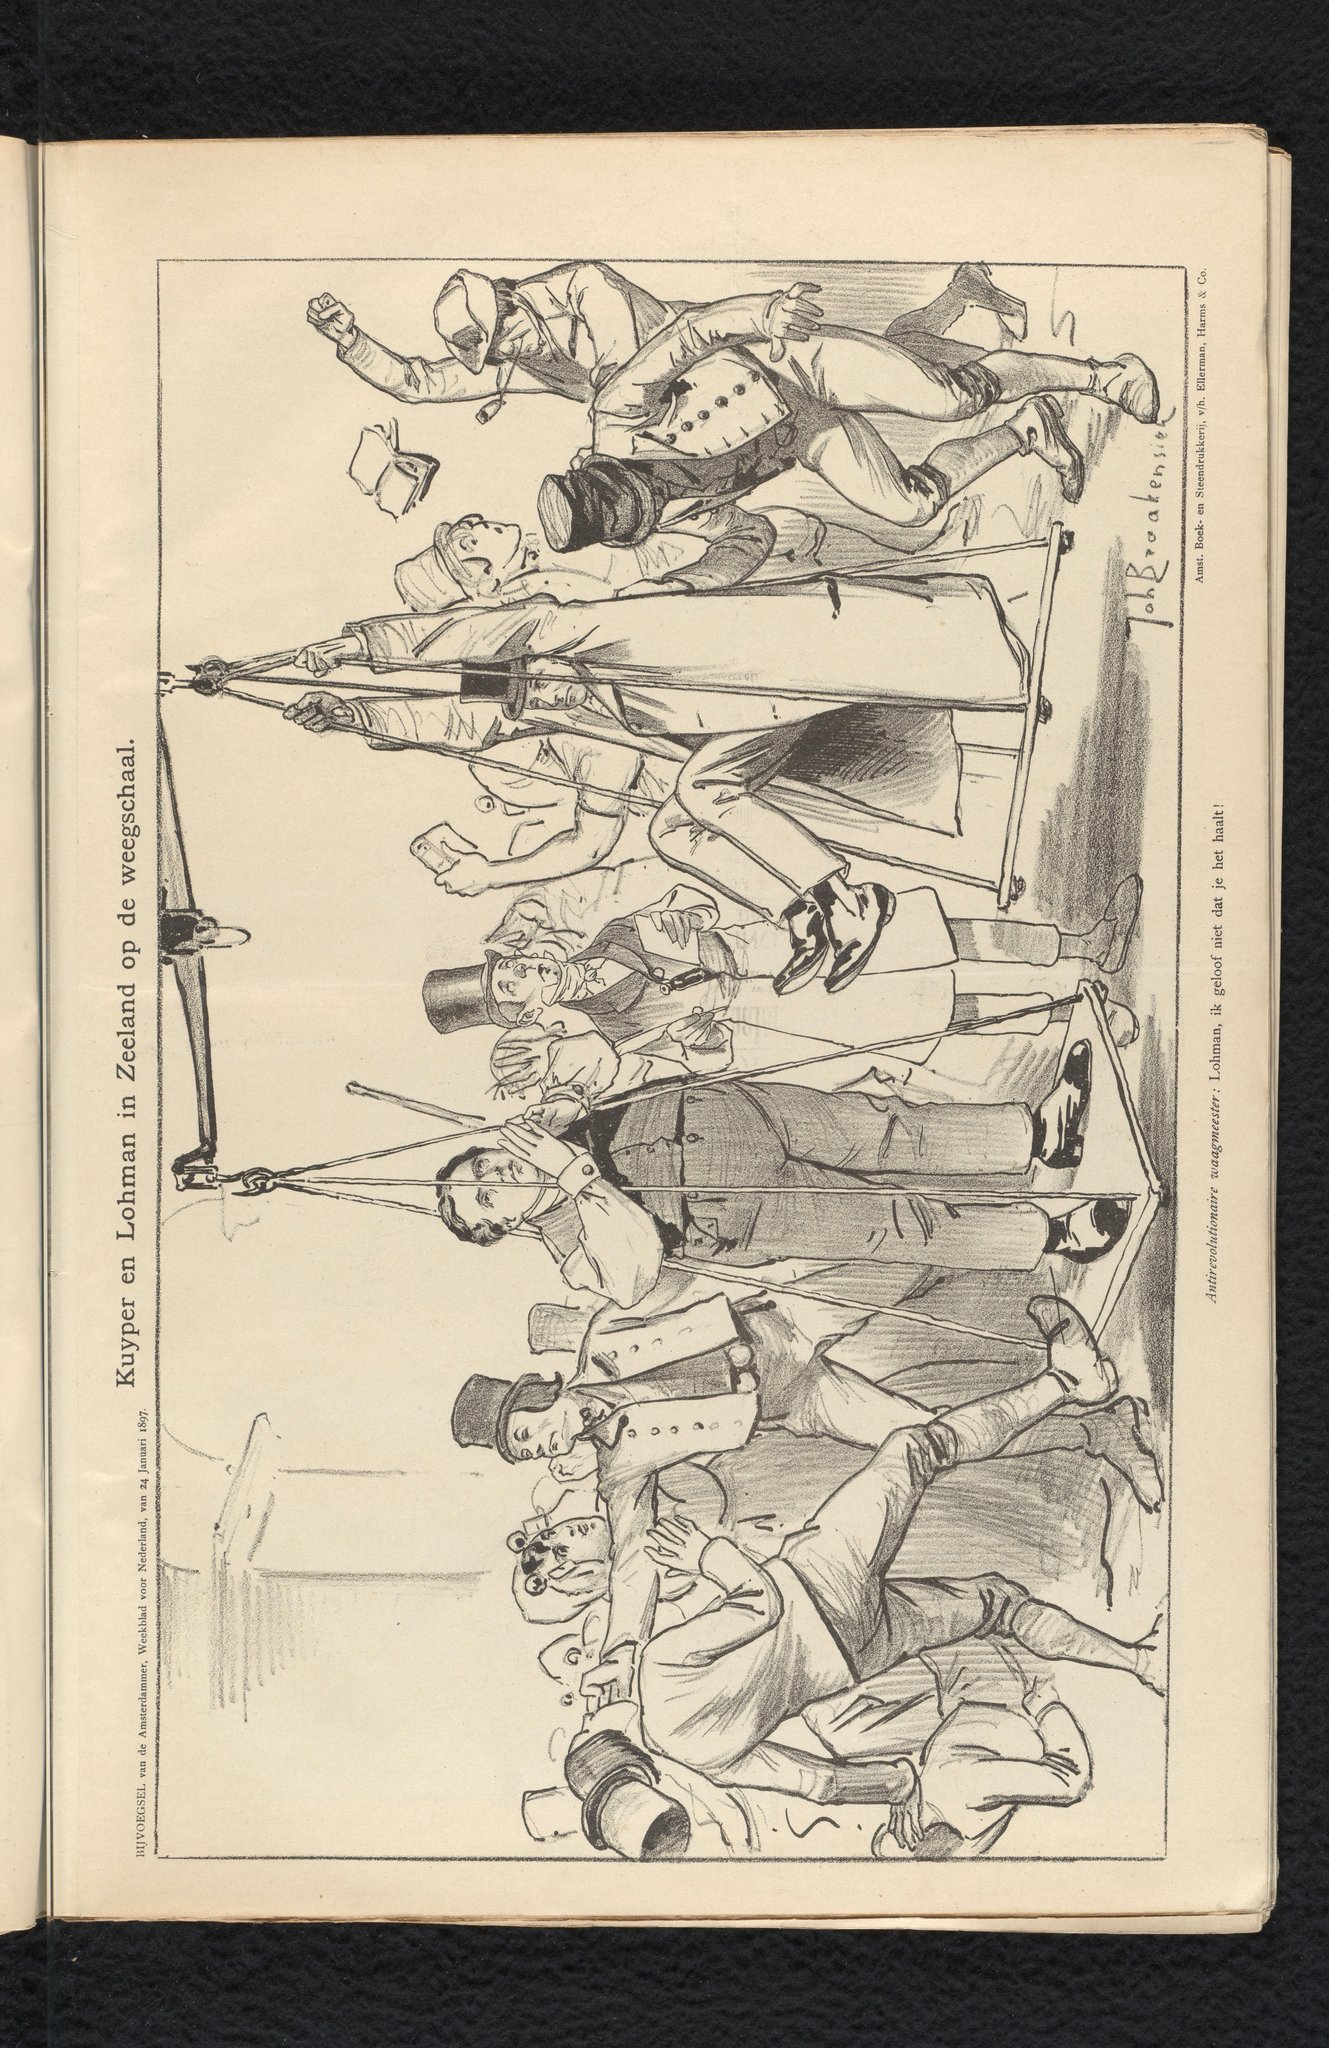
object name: cartoon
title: Kuyper en Lohman in Zeeland op de weegschaal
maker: johan braakensiek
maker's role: draughtsman, print maker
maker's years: 1858-1940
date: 1897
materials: paper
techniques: lithograph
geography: netherlands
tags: the hague, jonkheer alexander frederik de savornin lohman, abraham kuyper, weighing, political caricatures and satires, zeeland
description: De antirevolutionaire voormannen Abraham Kuyper en Alexander de Savornin Lohman worden op een weegschaal gewogen. Om de weegschalen heen vechten de omstanders.